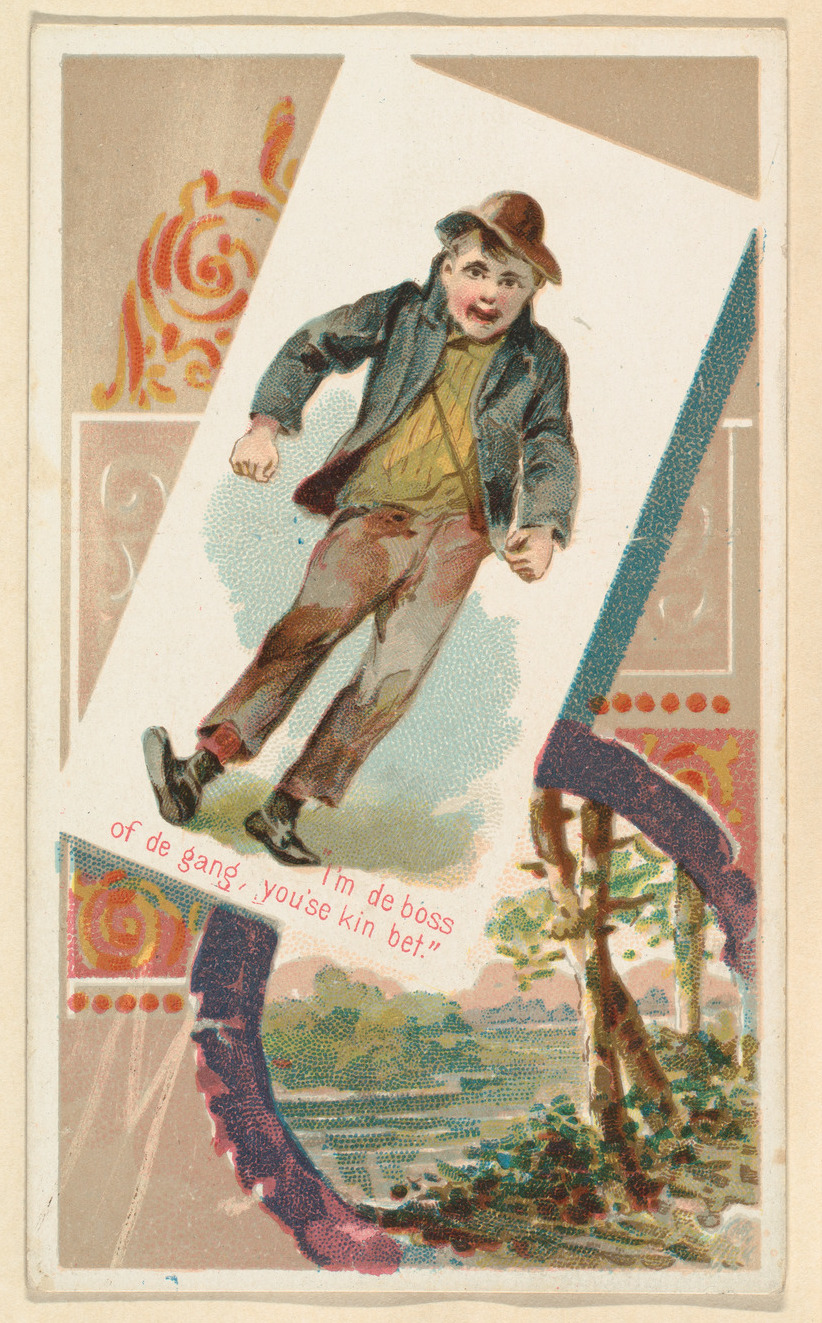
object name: print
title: "I'm de boss of de gang, you'se kin bet," from the Terrors of America set (N136) issued by Duke Sons & Co. to promote Honest Long Cut Tobacco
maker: w. duke, sons & co.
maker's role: publisher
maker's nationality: american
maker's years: 1870-1920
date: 1888-1889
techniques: color lithograph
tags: boys